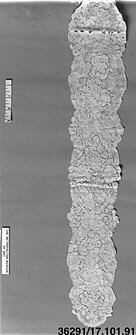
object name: lappet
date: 1701-1733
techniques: lace